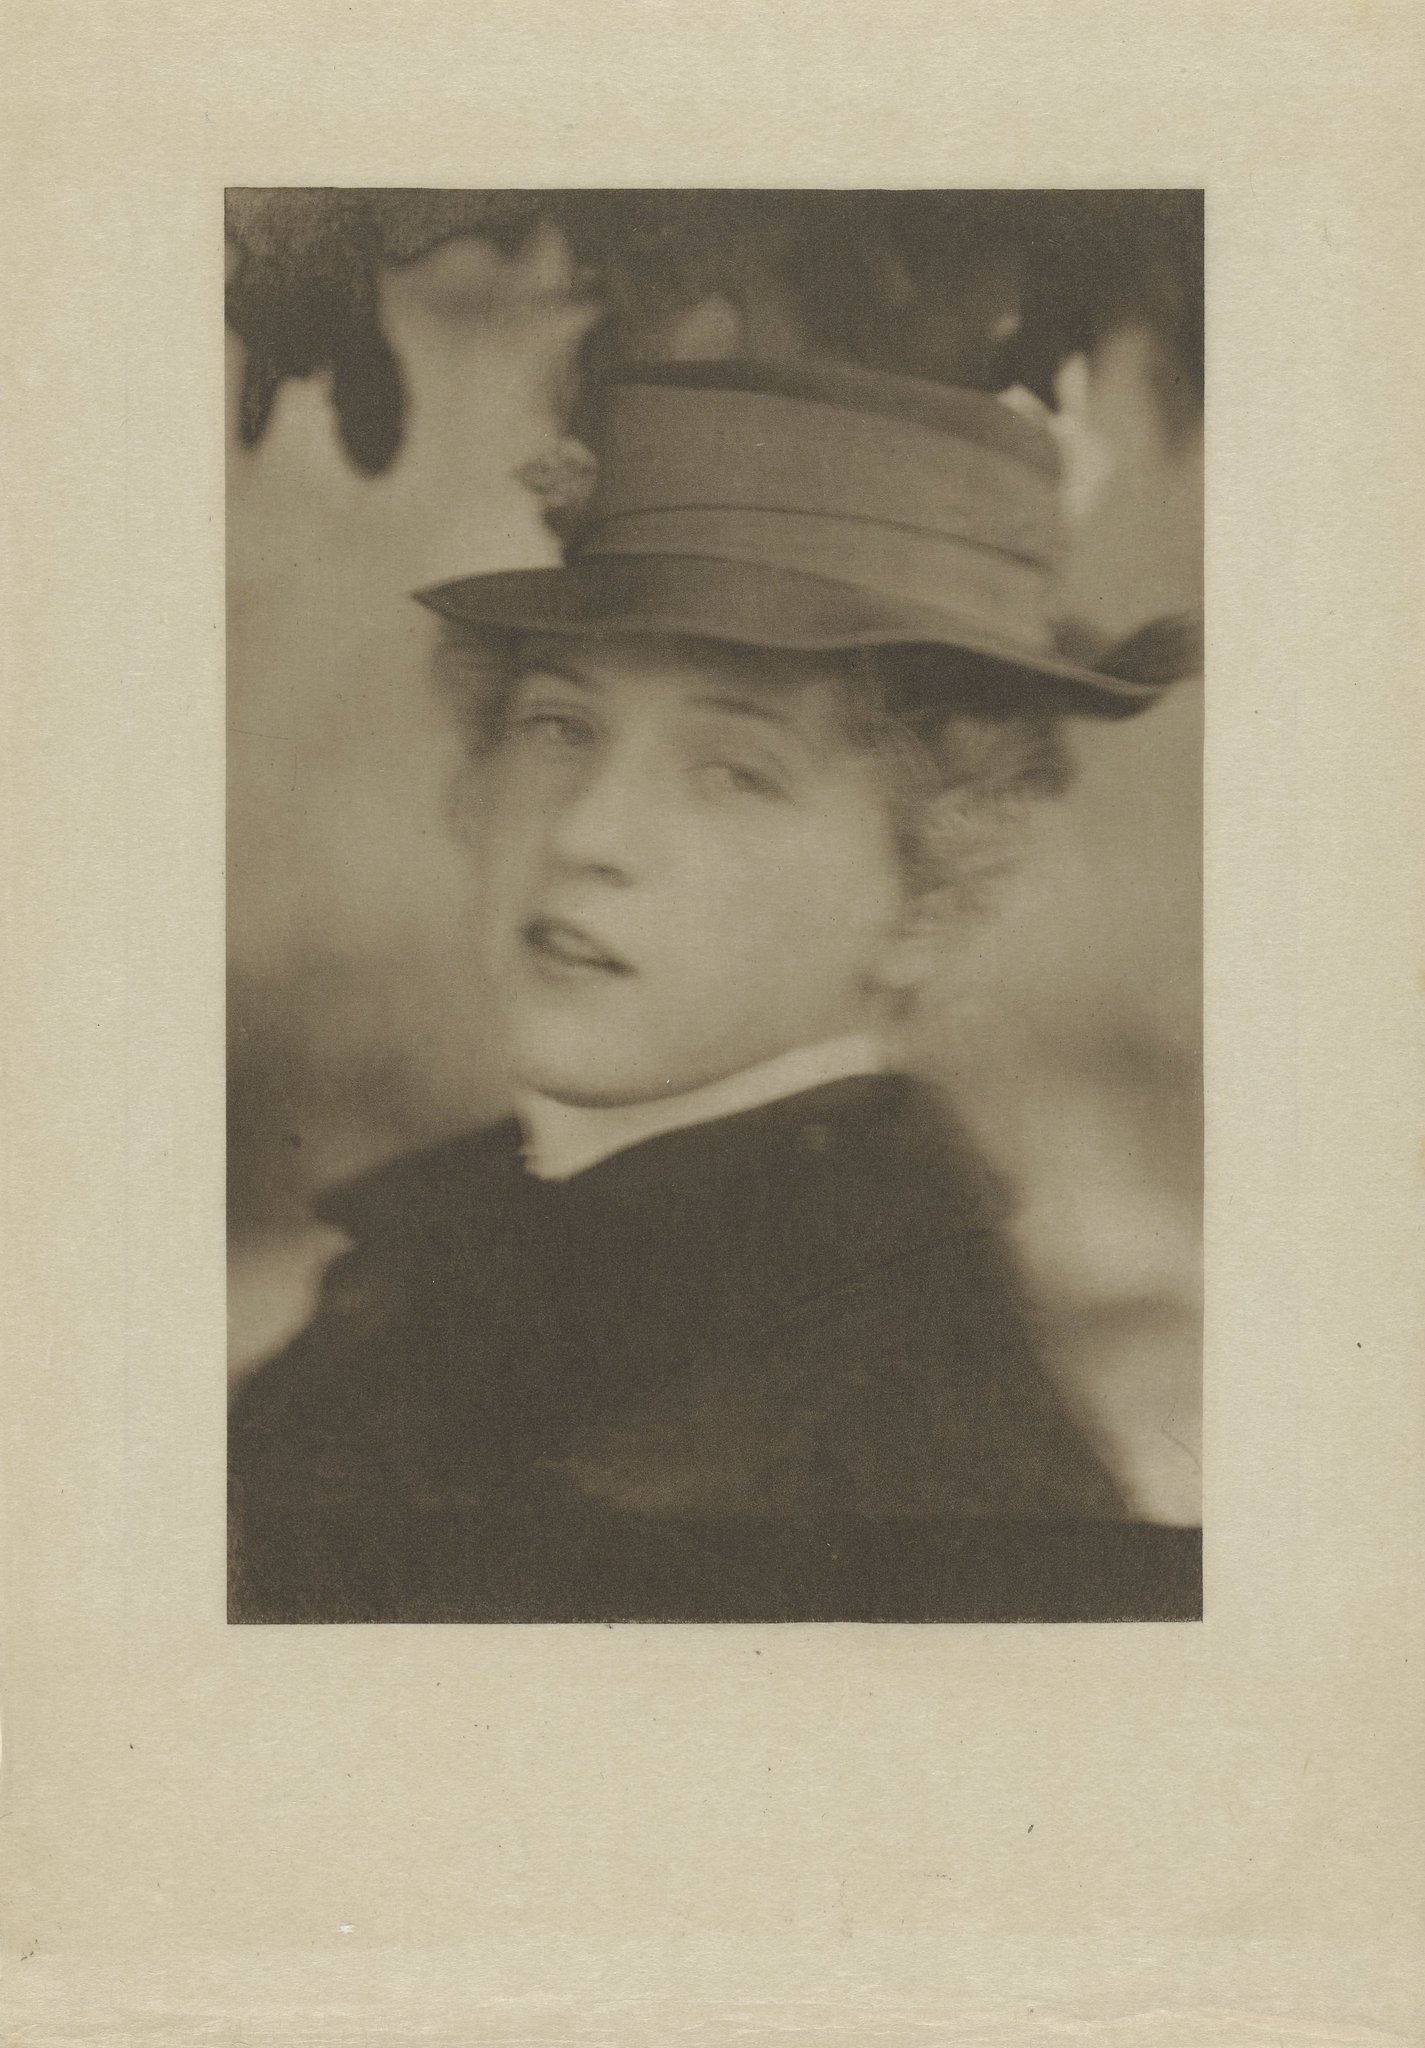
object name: photomechanical print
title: Portret van Miss S.R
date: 1904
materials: paper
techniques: photoaquatint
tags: historical persons - bb - woman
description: Gepubliceerd in Camera Work, oktober 1905.